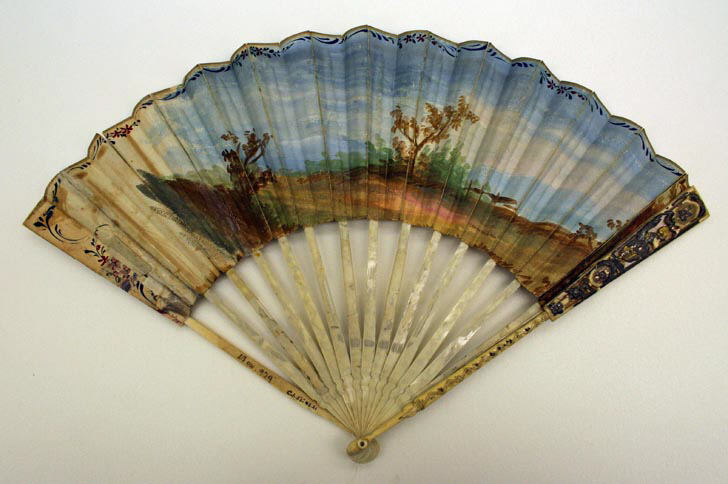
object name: fan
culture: french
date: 1701-1800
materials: gold, ivory, silver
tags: landscapes